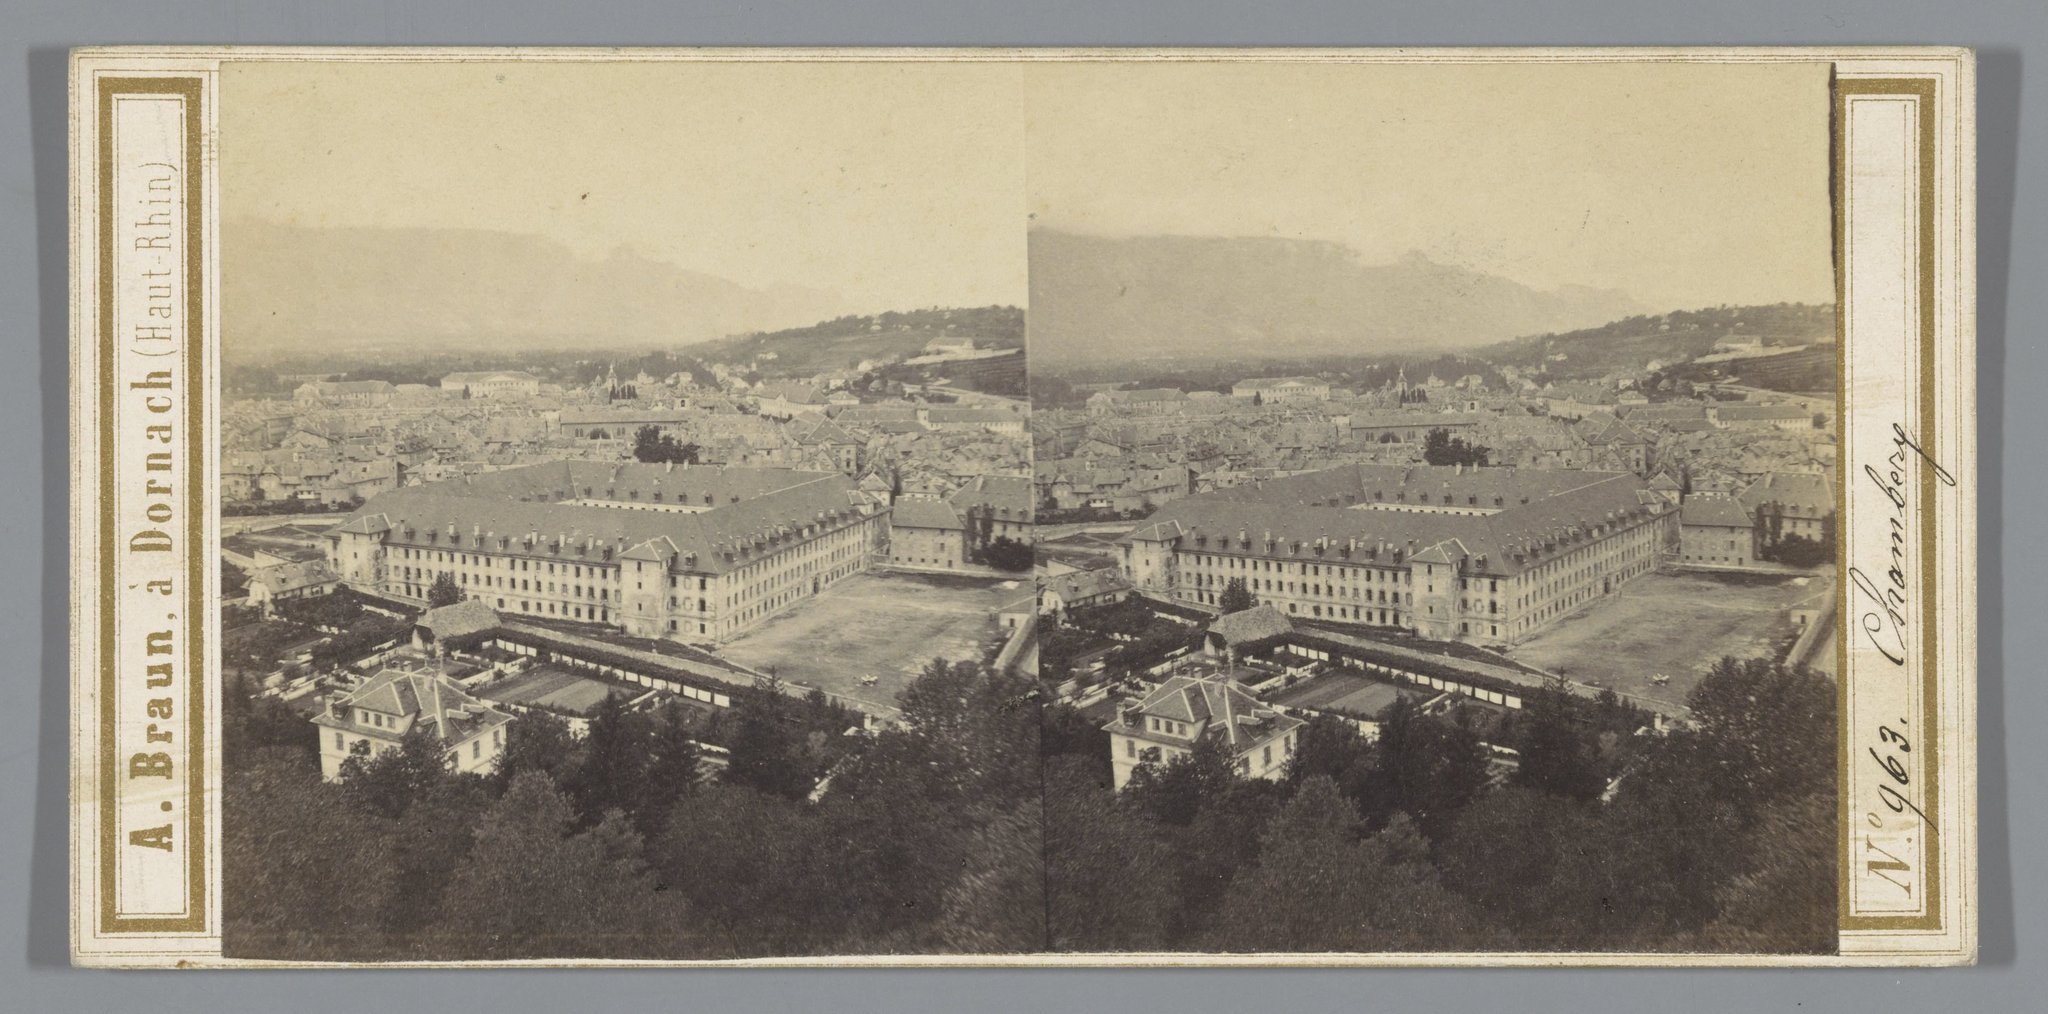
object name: stereograph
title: Gezicht op Chambéry, gezien vanaf de Colline de Bellevue, vooraan de voormalige militaire kazerne Carré Curial met erachter de kathedraal Saint-François-de-Salles, in de verte de Mont du Chat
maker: Anonymous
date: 1860-1866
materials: cardboard, paper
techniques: albumen print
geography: chambéry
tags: city-view in general; 'veduta'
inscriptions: number: ‘No. 963.’, inscription: ‘Chambéry Frankrijk’